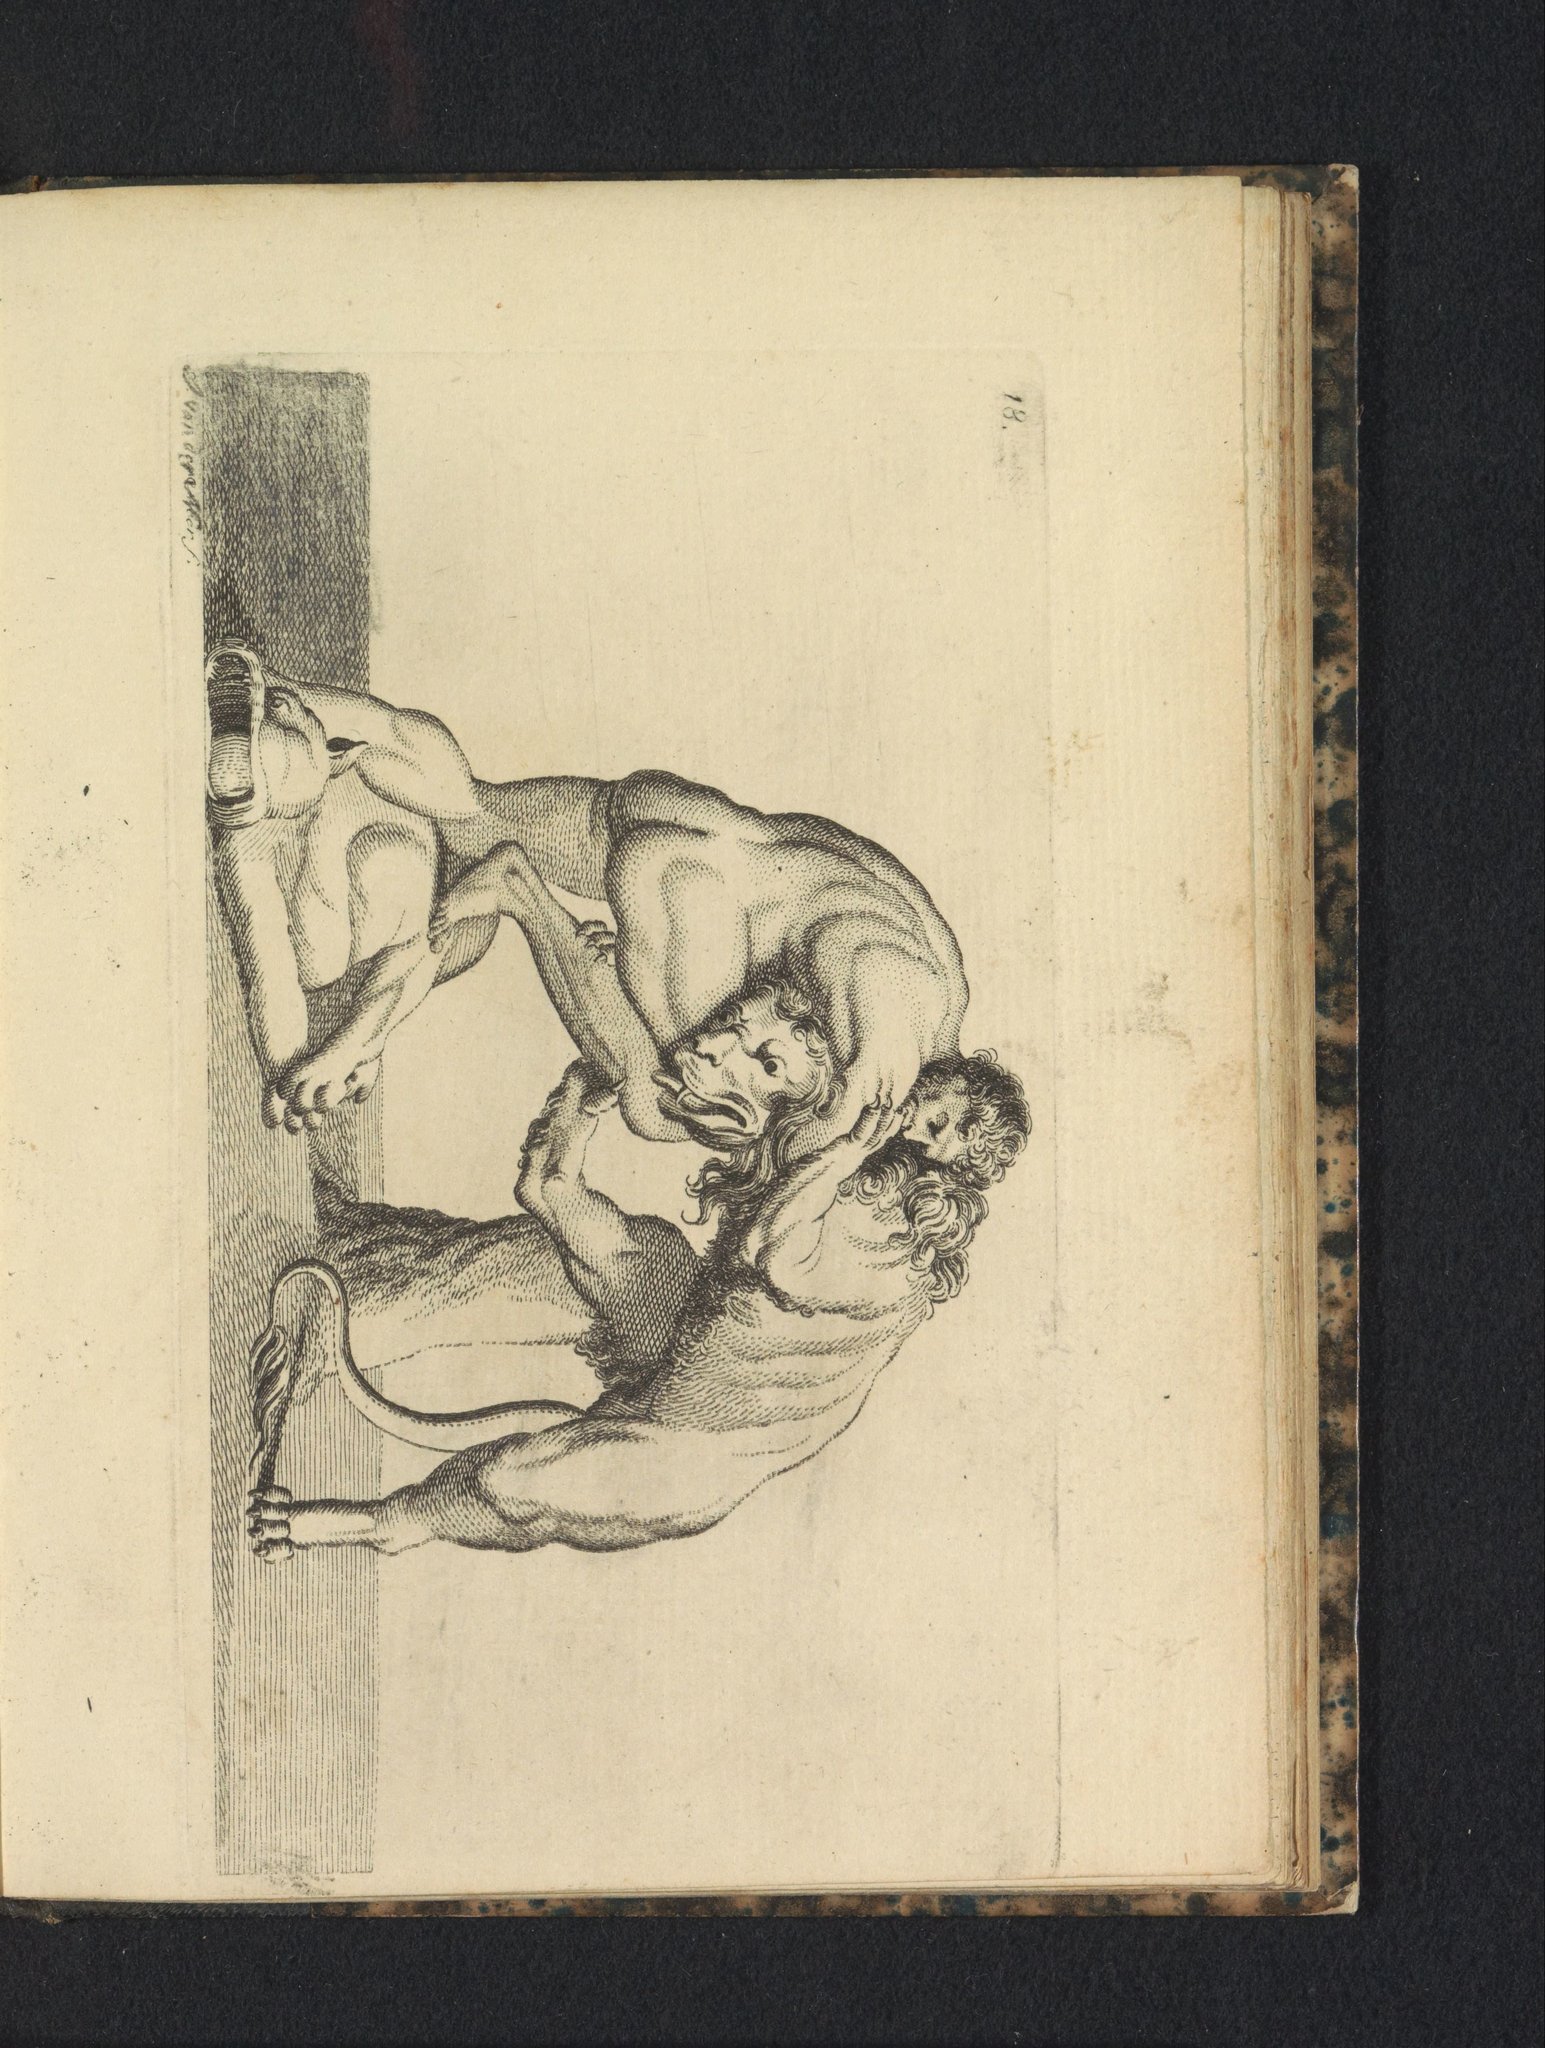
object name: print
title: David doodt een leeuw en een beer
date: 1772-1773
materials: paper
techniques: engraving, etching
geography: southern netherlands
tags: david kills a lion and a bear (or tells saul about it), piece of sculpture, reproduction of a piece of sculpture (+ clay, sand, etc. ~ arts), antwerp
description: Sculptuur van David vechtend met een leeuw, een beer ligt verslagen op de grond. Beeld gemaakt door Jaques vander Neer naar een model door Verbruggen. Genummerd linksboven in de plaat: 18. Onderdeel van de verzameling van figuren en beelden gemaakt van sneeuw in de straten van Antwerpen in januari 1772.